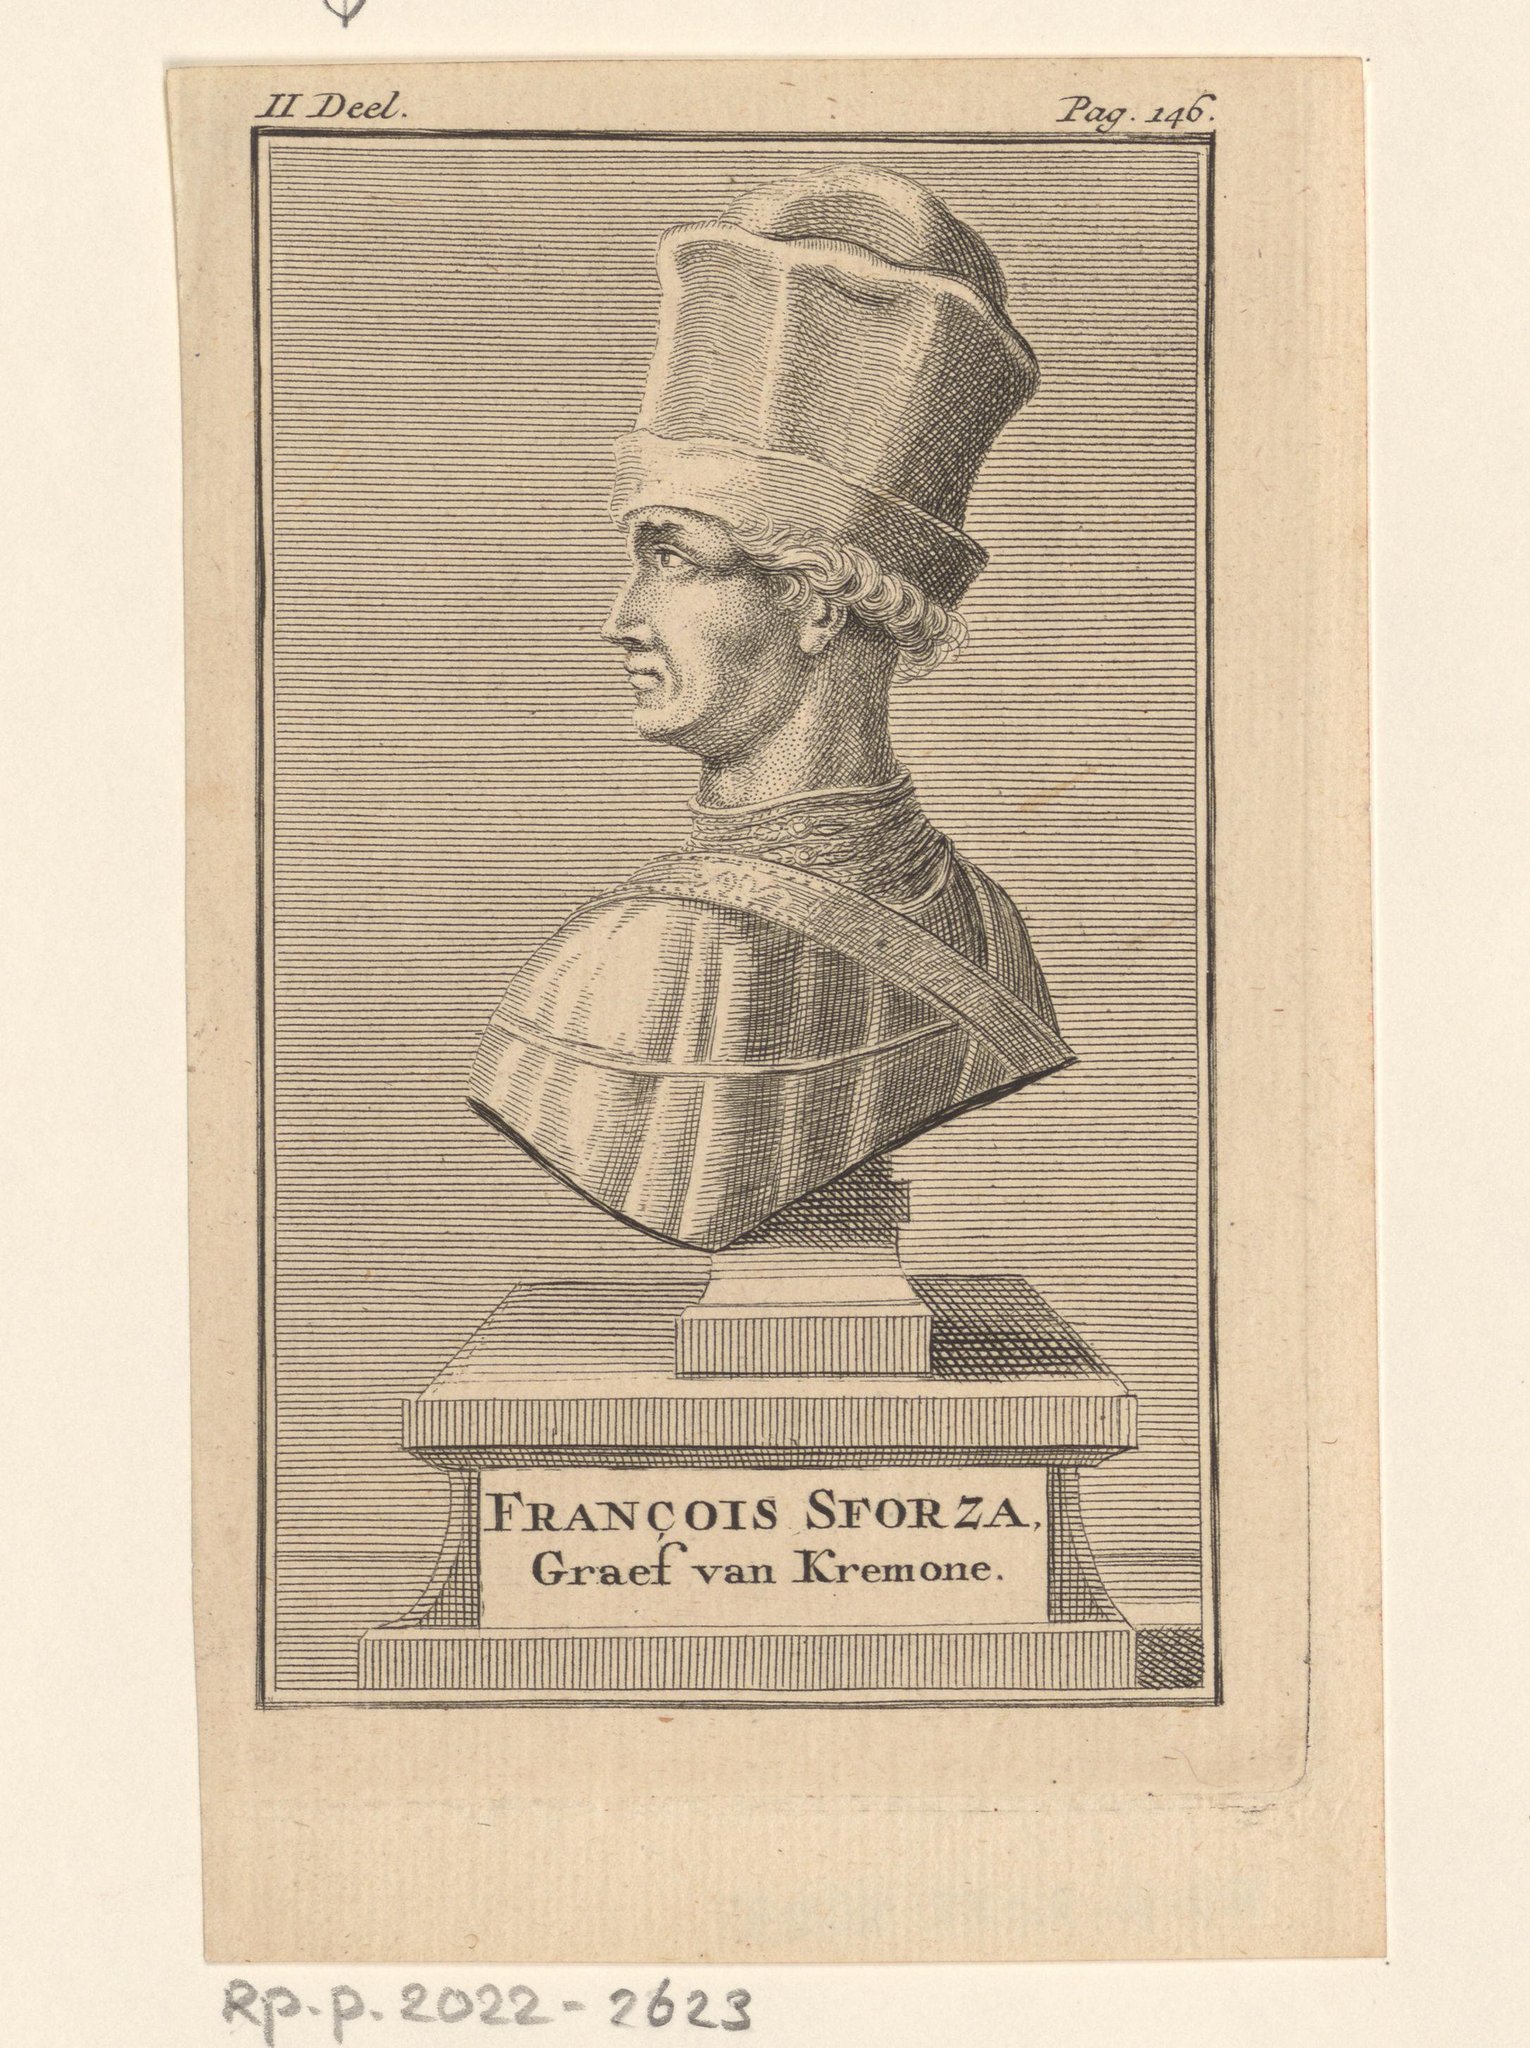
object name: print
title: Portret van Francesco I Sforza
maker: Anonymous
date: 1738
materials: paper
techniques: engraving, etching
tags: historical persons, other sovereign (with title)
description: Prent waarschijnlijk uit: Leti, Gregorio. Het leven van keizer Karel, den Vyfden. Leiden en Amsterdam: J. en H. van der Deyster en J. Roman de Jonge, 1738., dl. 2.1.